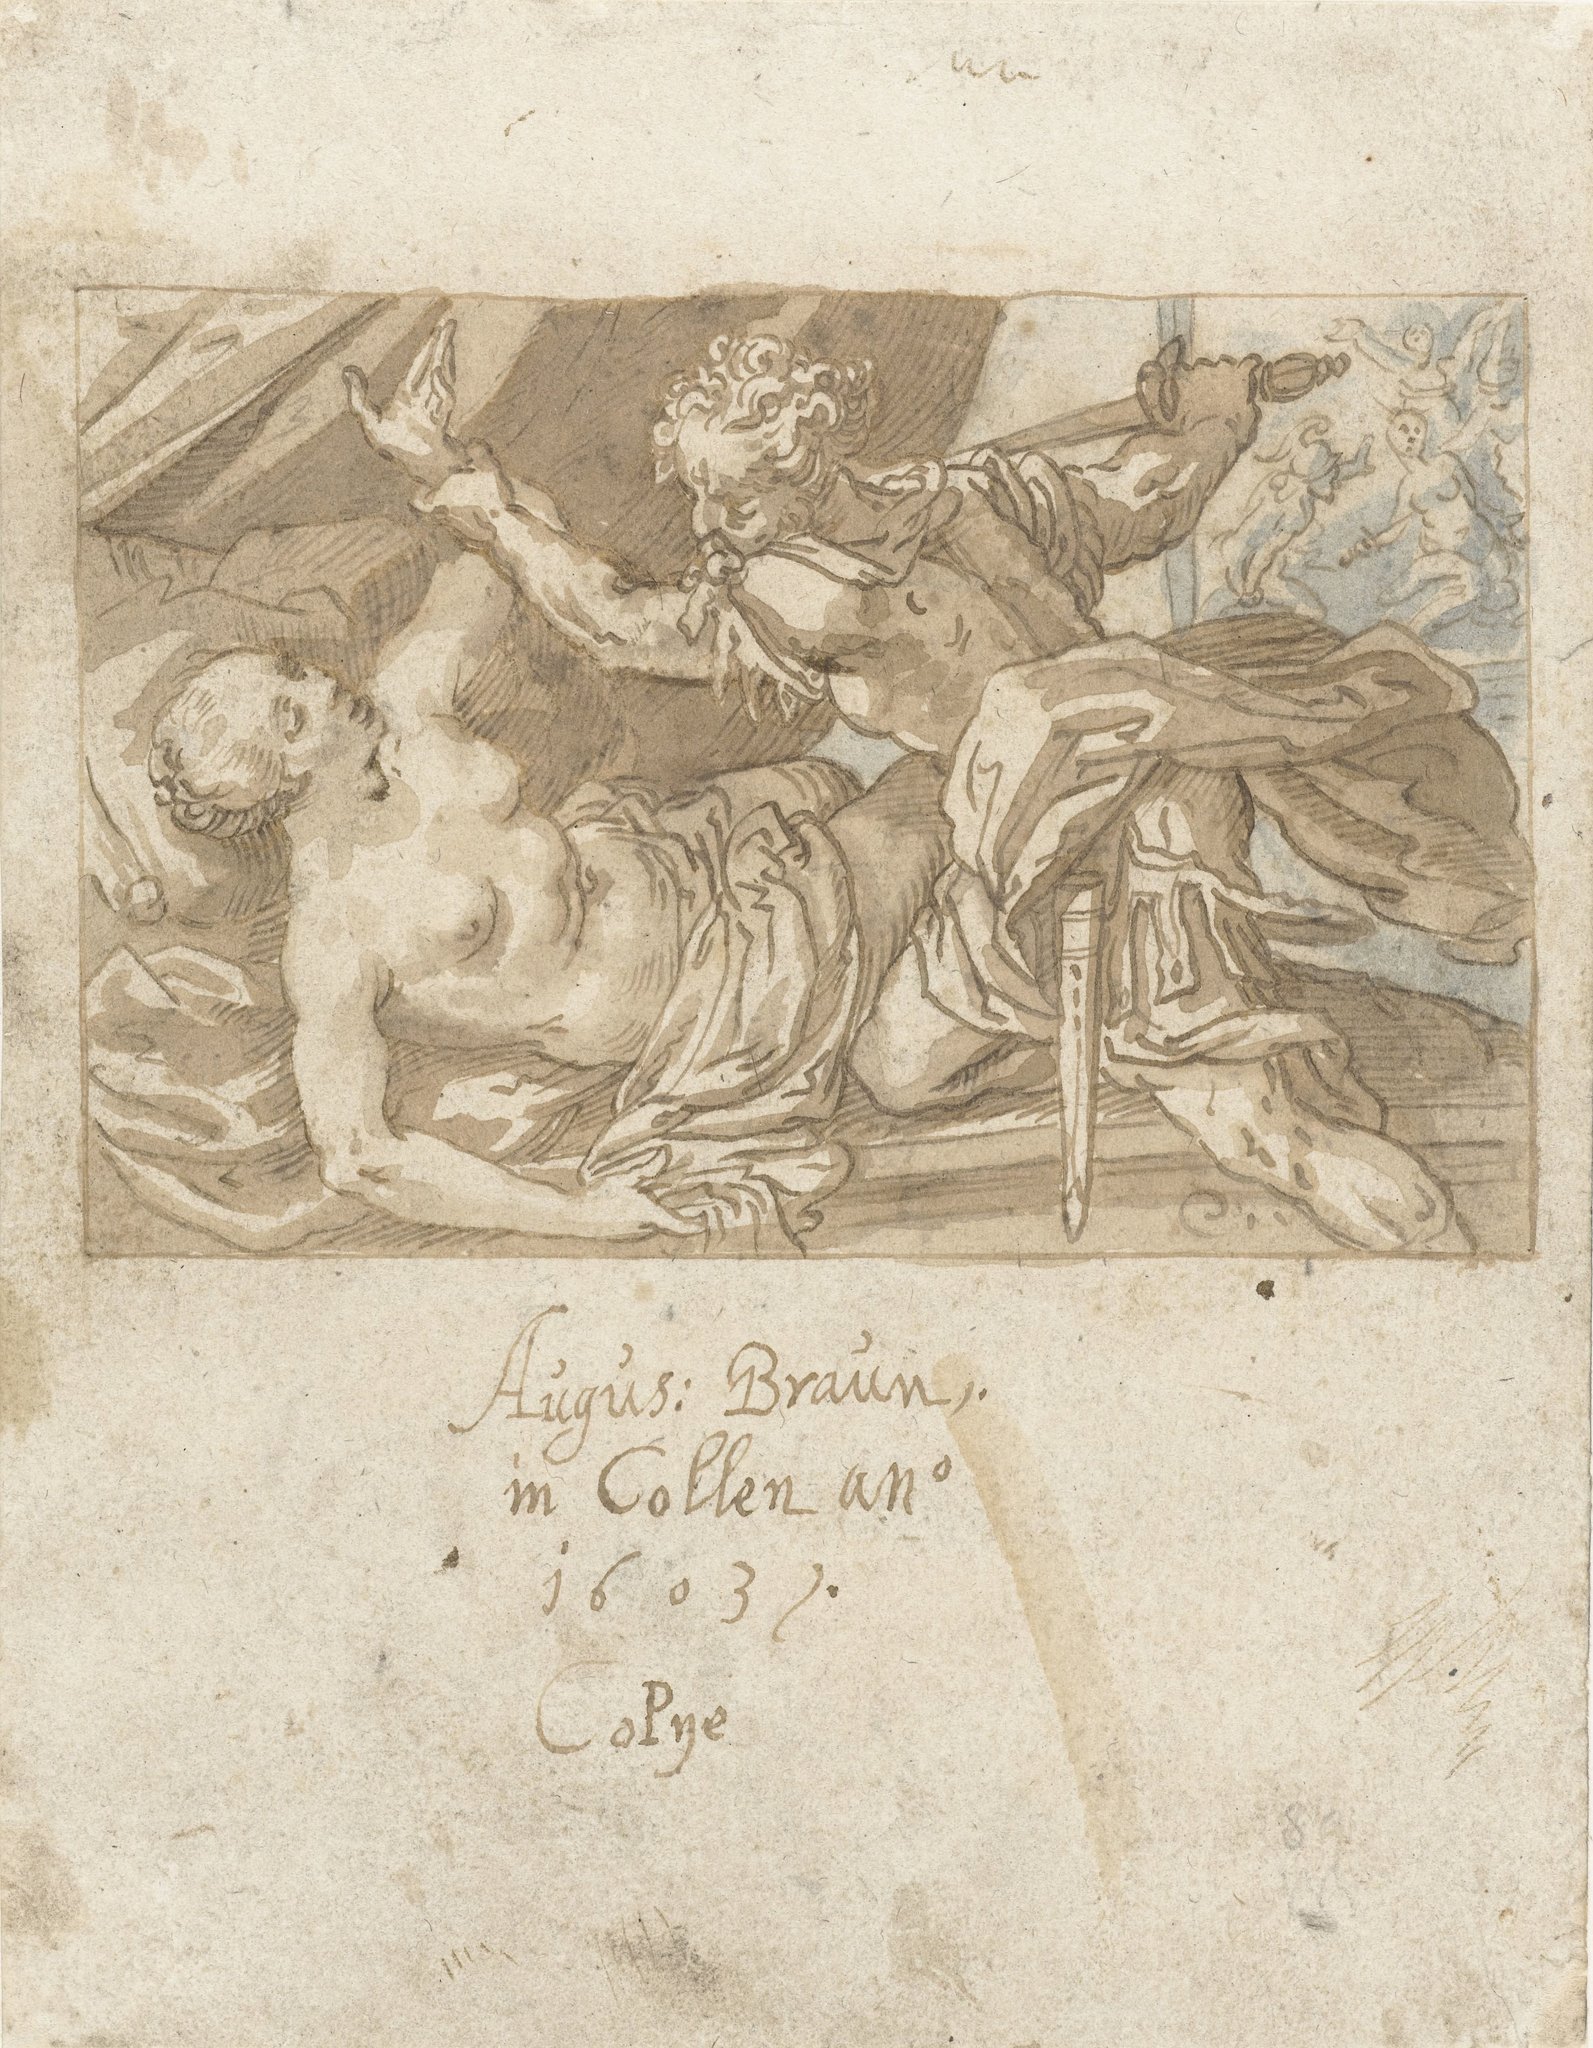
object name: drawing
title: Rape of Lucretia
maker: gerard ter borch (i)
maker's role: draughtsman, print maker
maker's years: 1584-1662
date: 1603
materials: ink, paper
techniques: brush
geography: cologne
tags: the rape of lucretia: sextus tarquin threatens her with a dagger or a sword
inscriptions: number: ‘89’, date and inscription: ‘Augus: Braun/ in Collen An°/ 1603/ Copye’